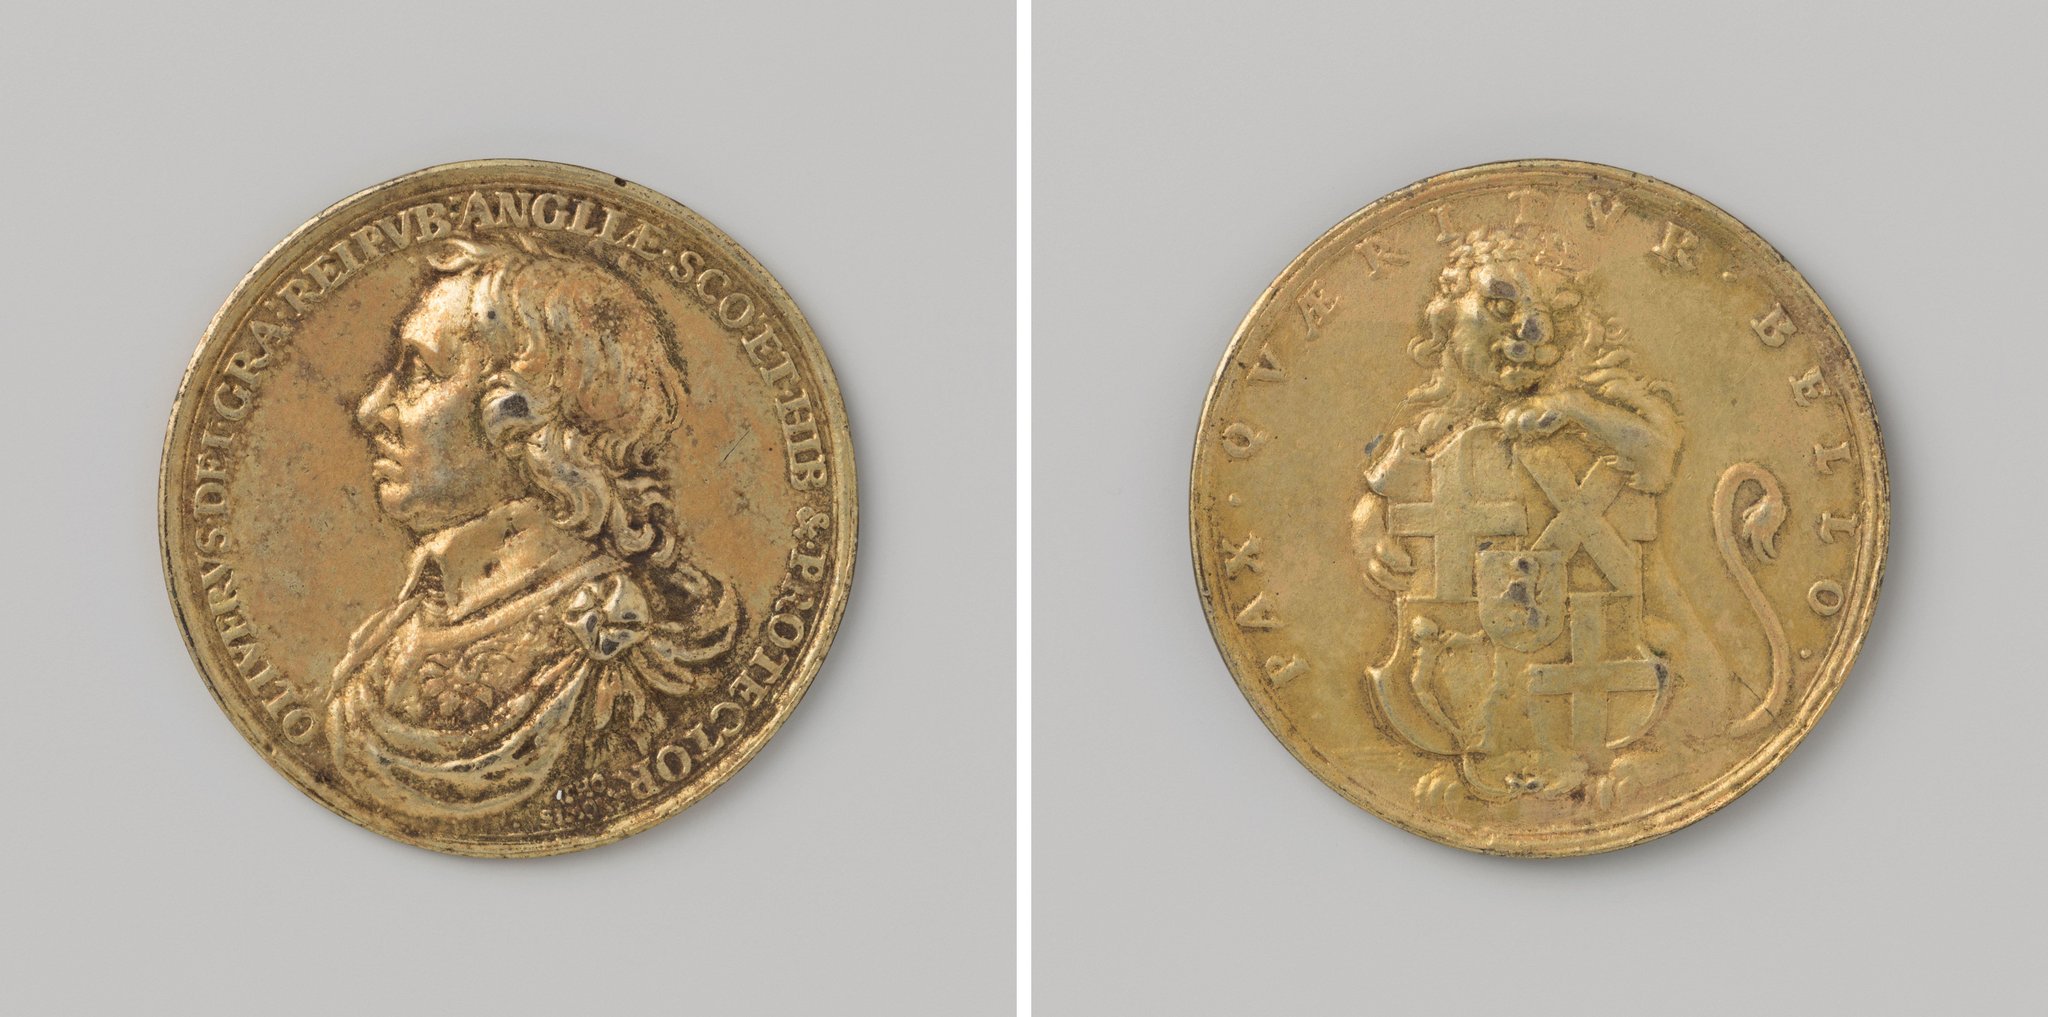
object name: history medal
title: Oliver Cromwell, Lord Protector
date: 1653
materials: silver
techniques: casting, gilding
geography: london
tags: oliver cromwell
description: Zilveren penning. Voorzijde: borststuk man binnen omschrift. Keerzijde: leeuw met lauwerkrans en wapenschild binnen omschrift